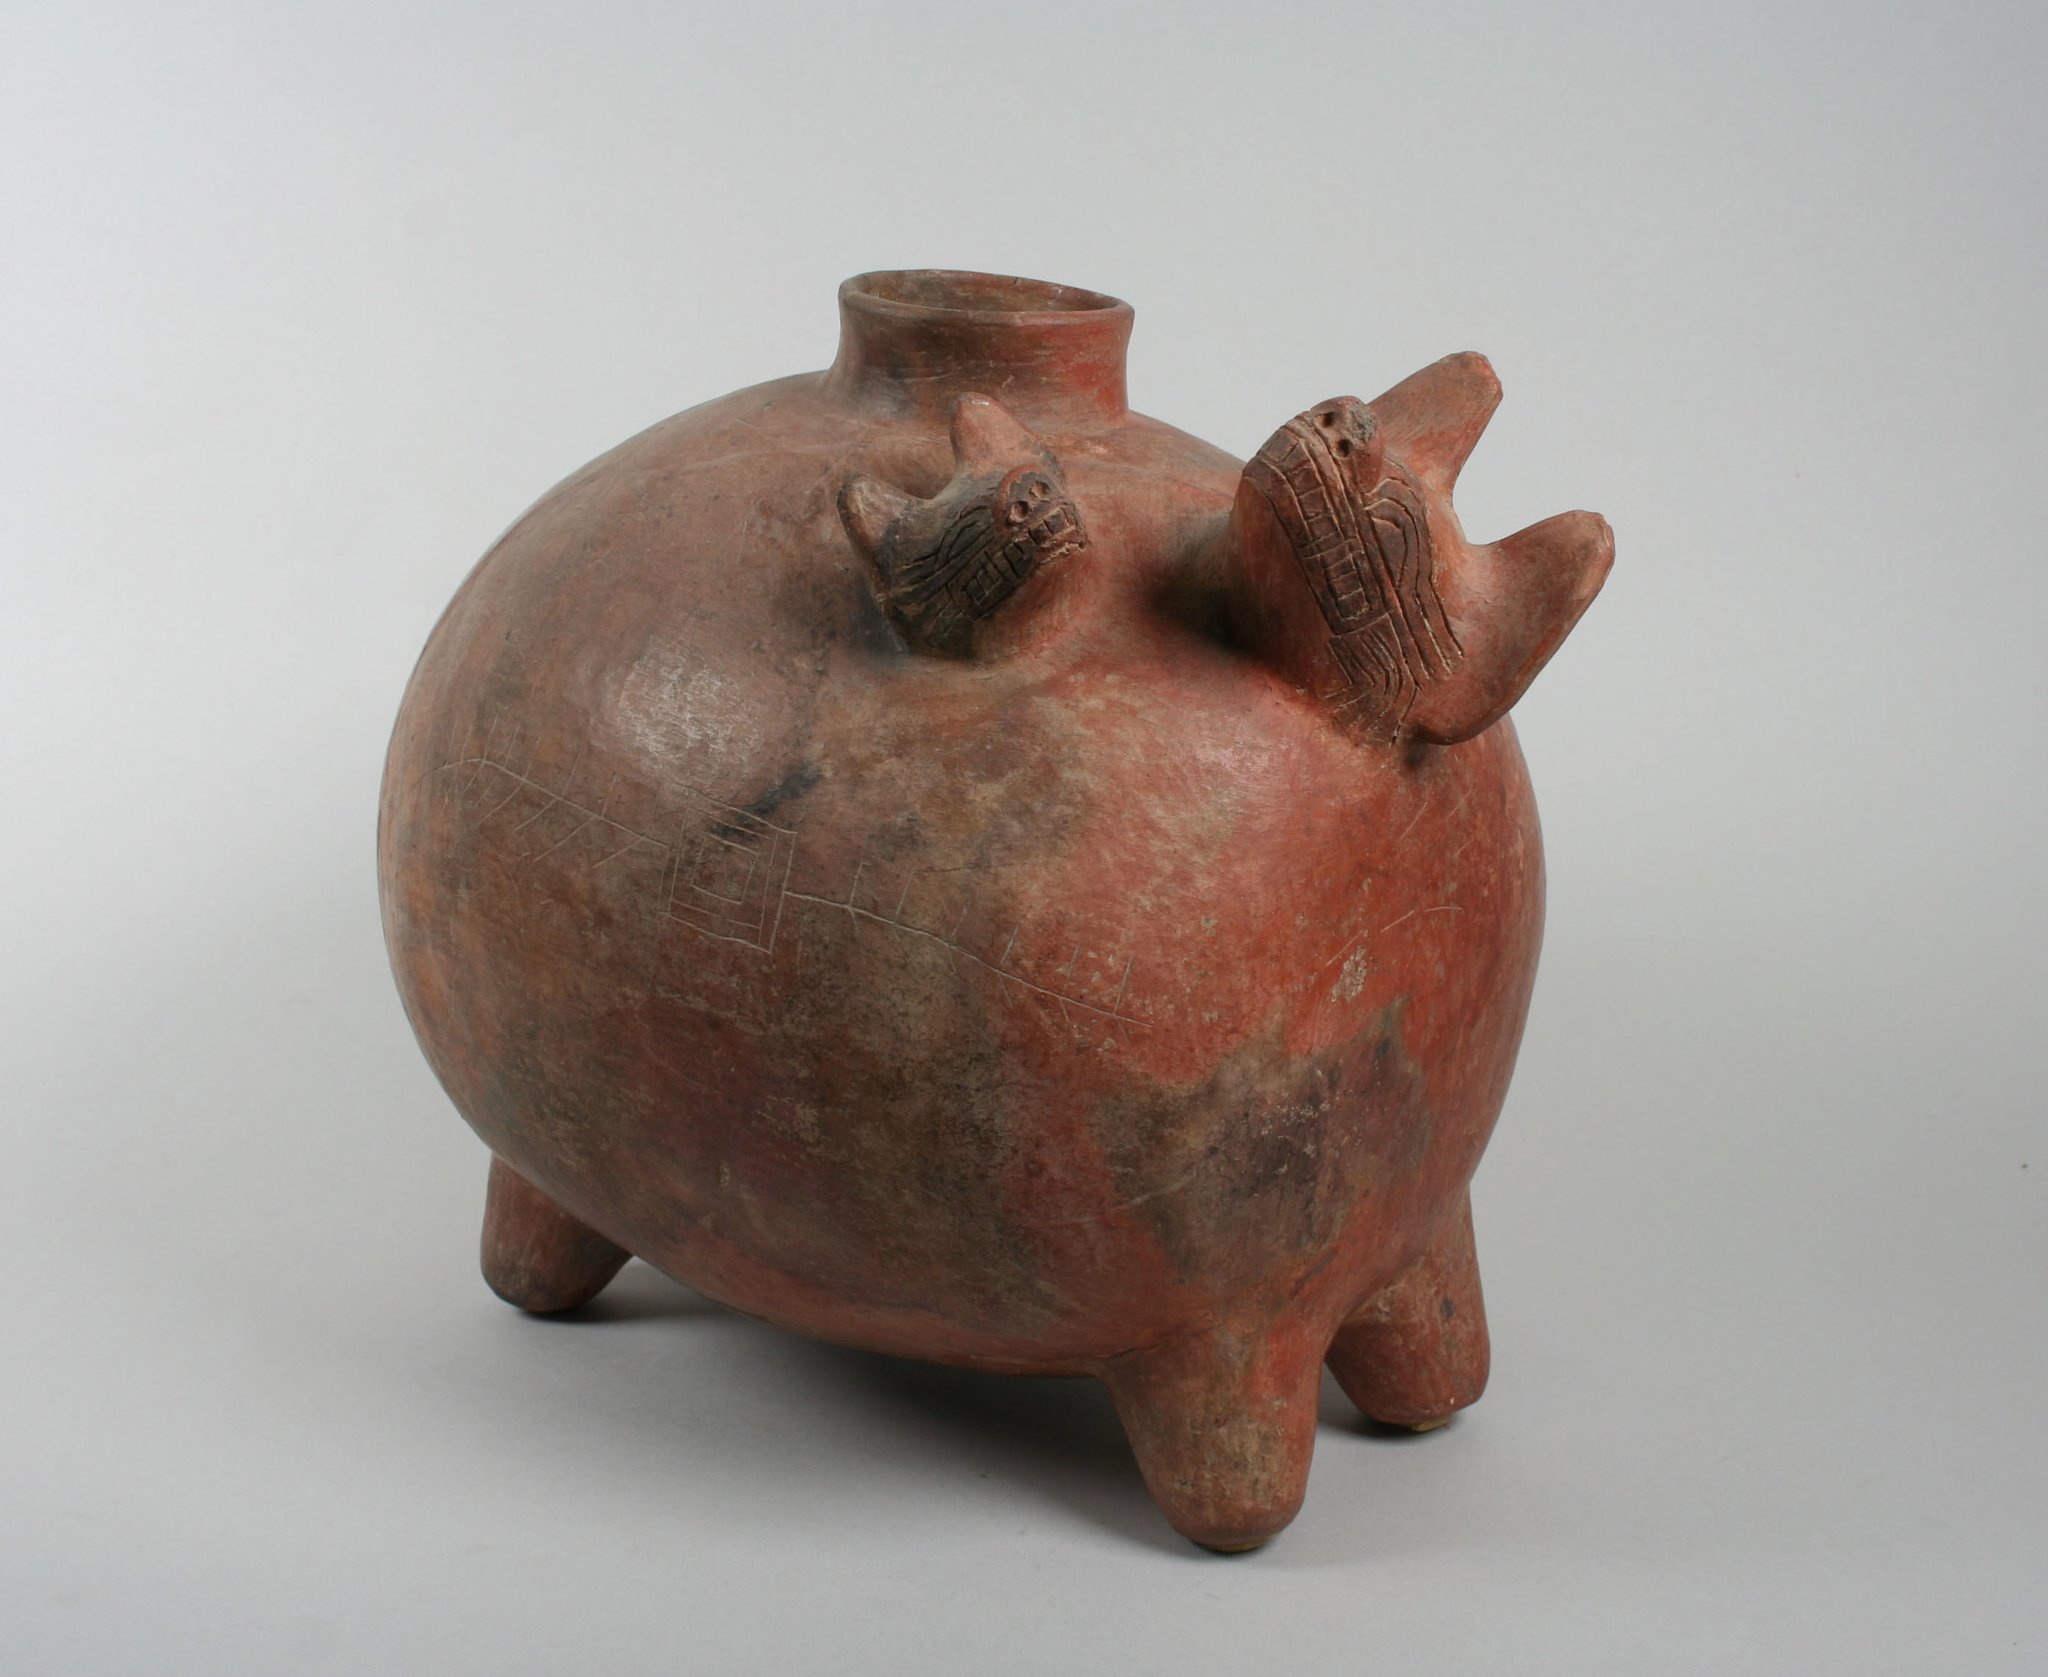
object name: bottle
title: Fox Effigy Bottle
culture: paracas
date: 700-301 BCE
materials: ceramic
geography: peru